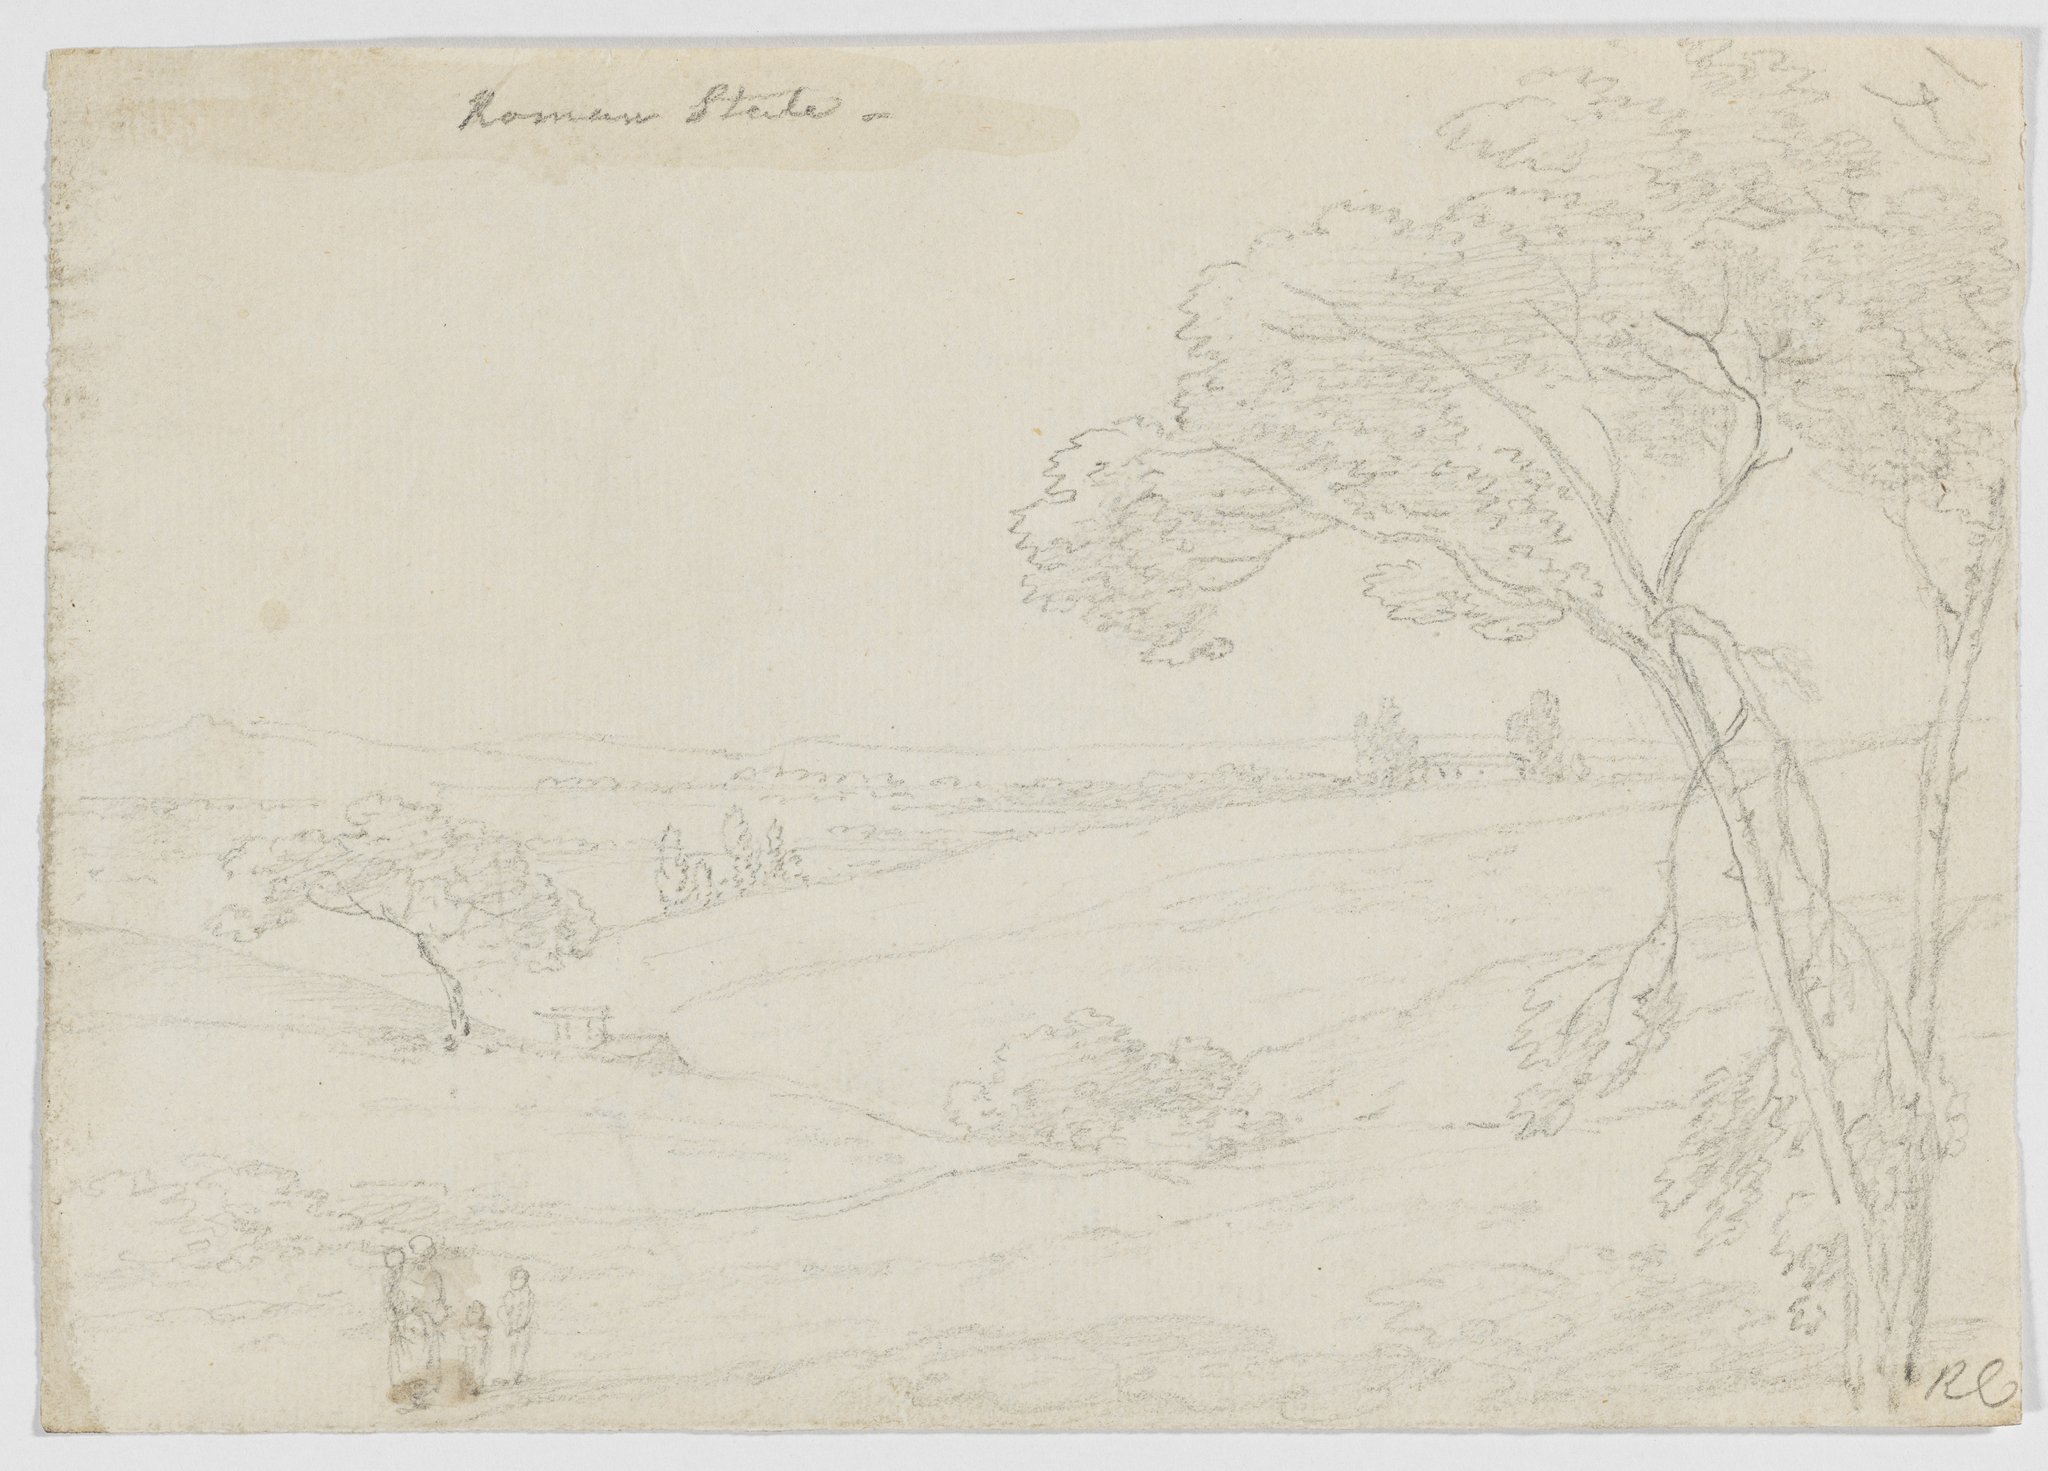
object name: drawing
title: Roman State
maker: richard cooper ii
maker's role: artist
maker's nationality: british, scottish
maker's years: 1740-1822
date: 1774-1775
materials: graphite